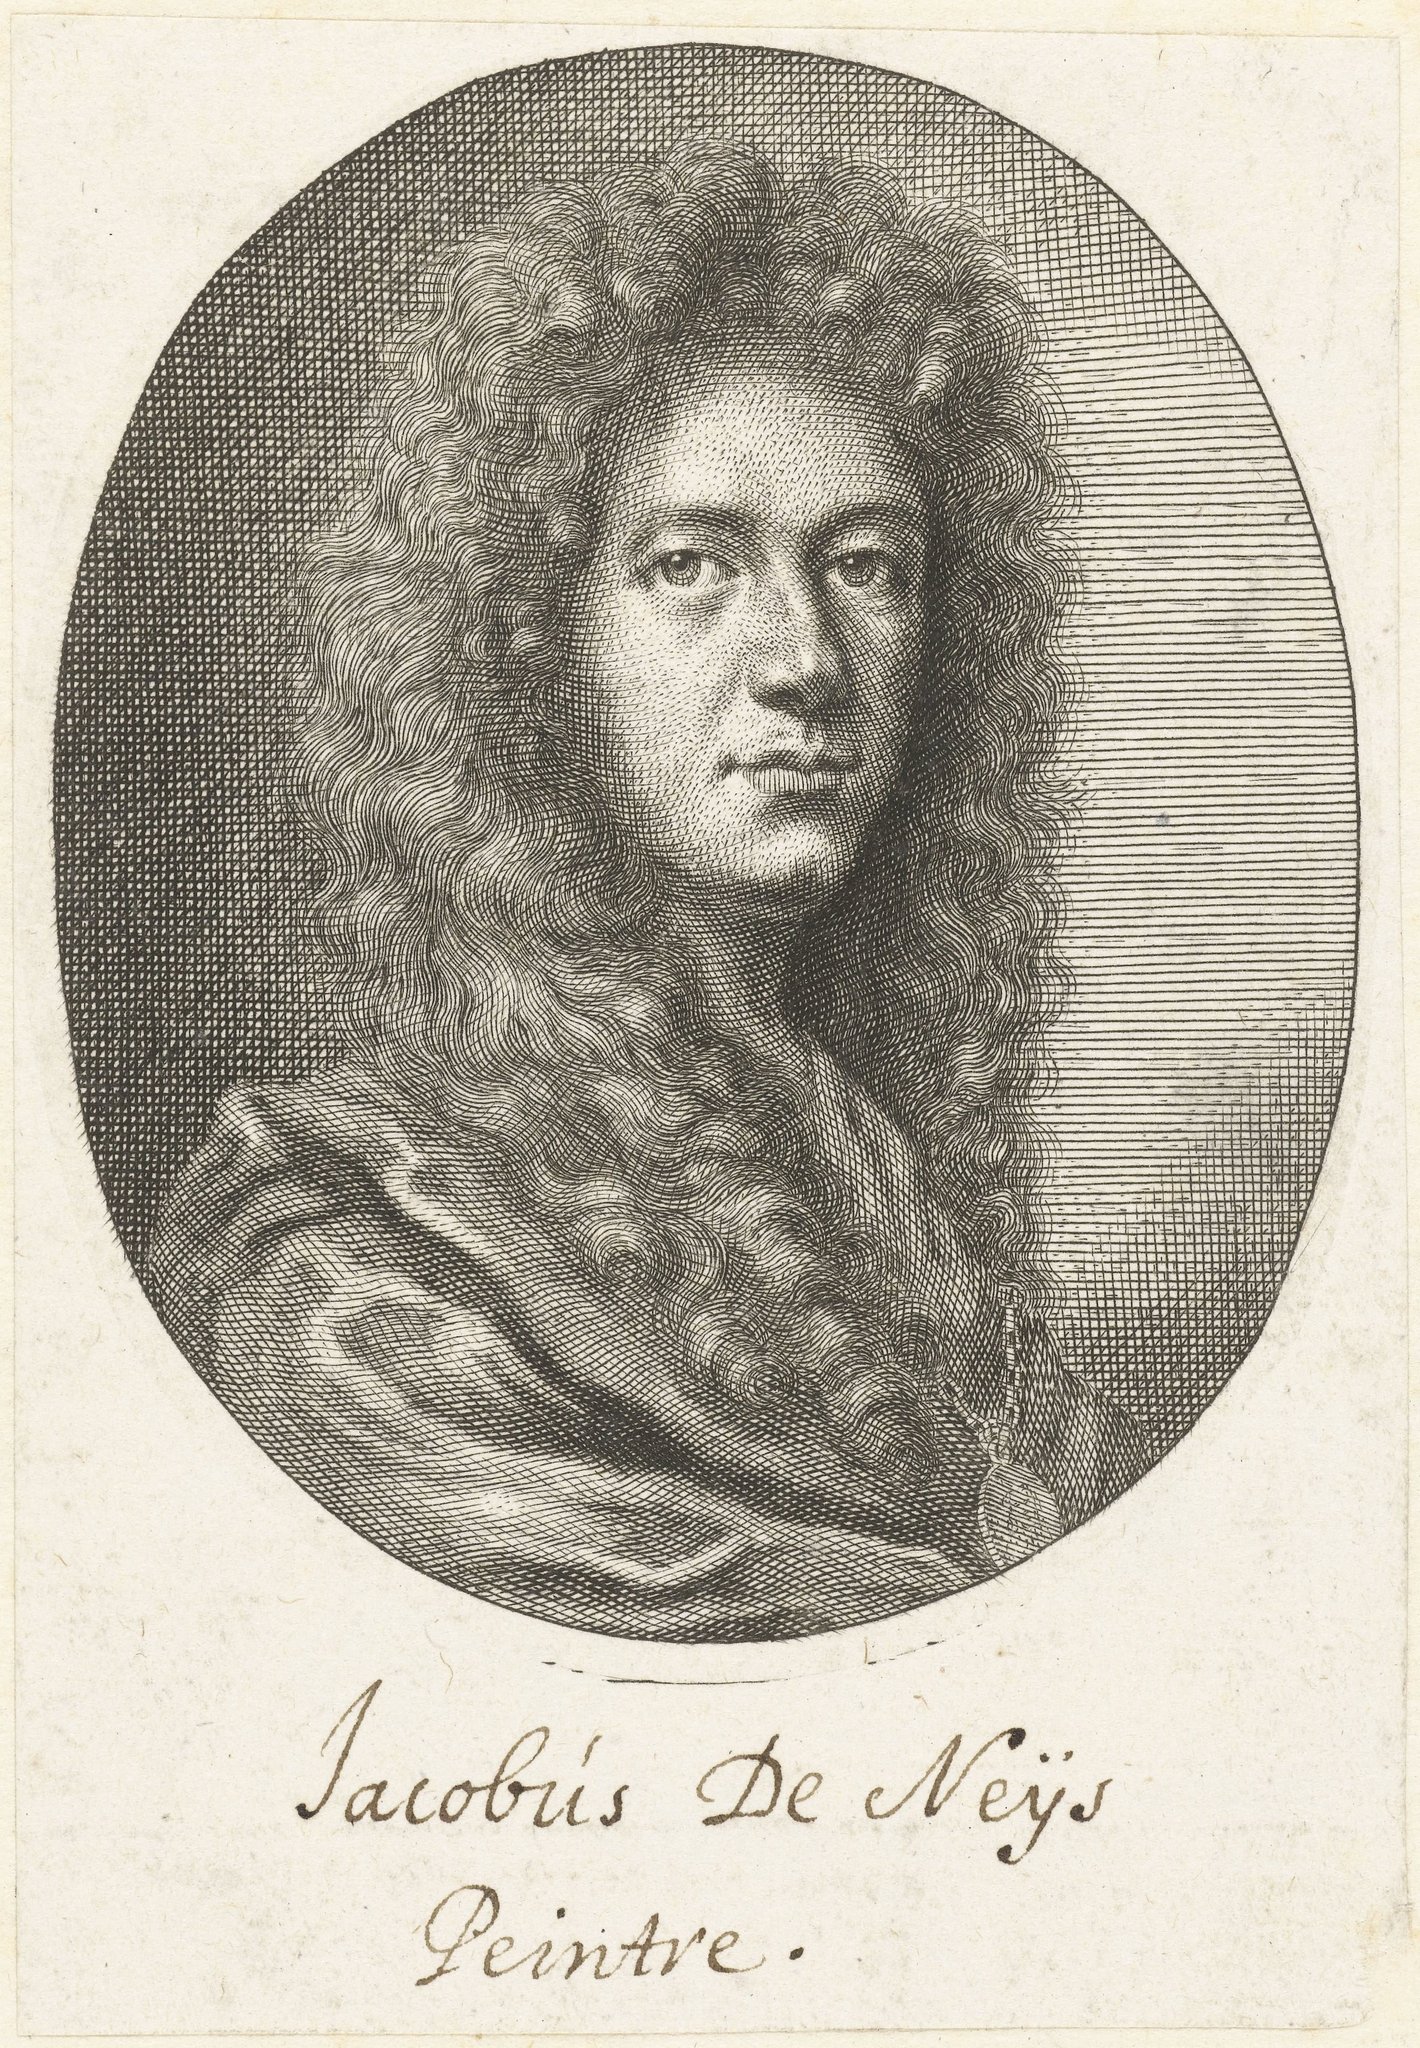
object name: print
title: Portret van de schilder Jacob Denys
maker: richard collin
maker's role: print maker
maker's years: 1627-1697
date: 1650-1694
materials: paper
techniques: engraving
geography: southern netherlands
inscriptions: collector's mark: Lugt 2760, collector's mark: Lugt 2228, inscription: ‘Jacobus De Neijs Peintre.’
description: Behoort tot de Verzameling Gerritsen, kunstenaarsportretten